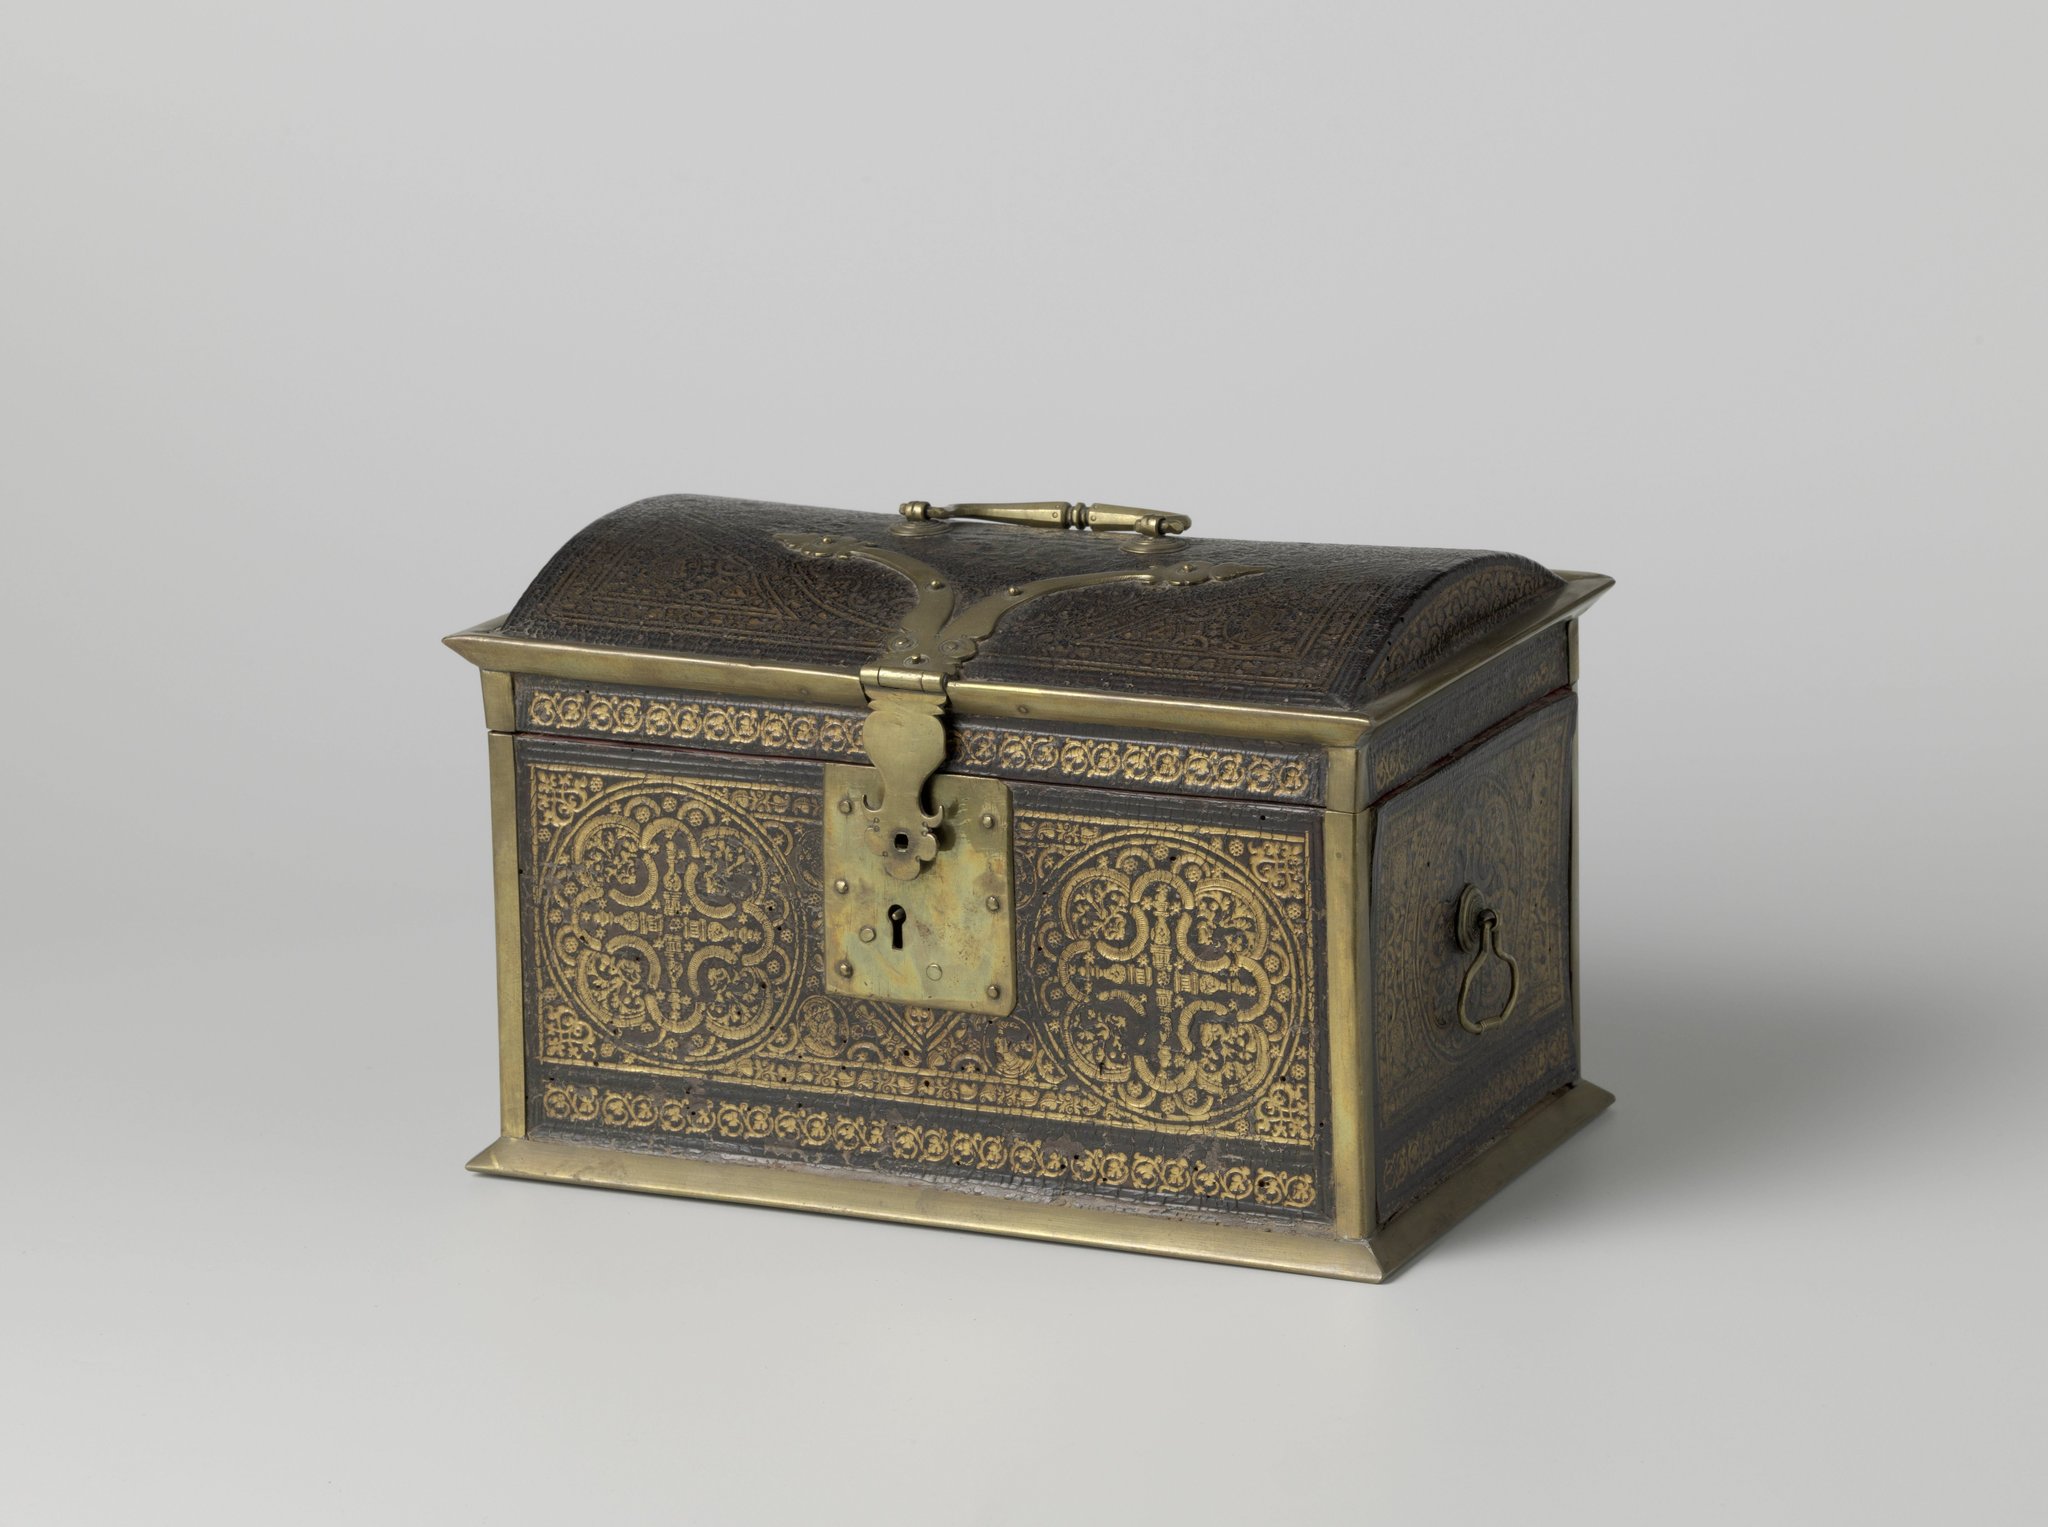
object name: suitcase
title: Goudleren koffer met koperen randen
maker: Anonymous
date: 1600-1625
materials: brass, gilt leather, leather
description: Goudleren koffer met gebombeerde deksel, nieuwe koperen randen.